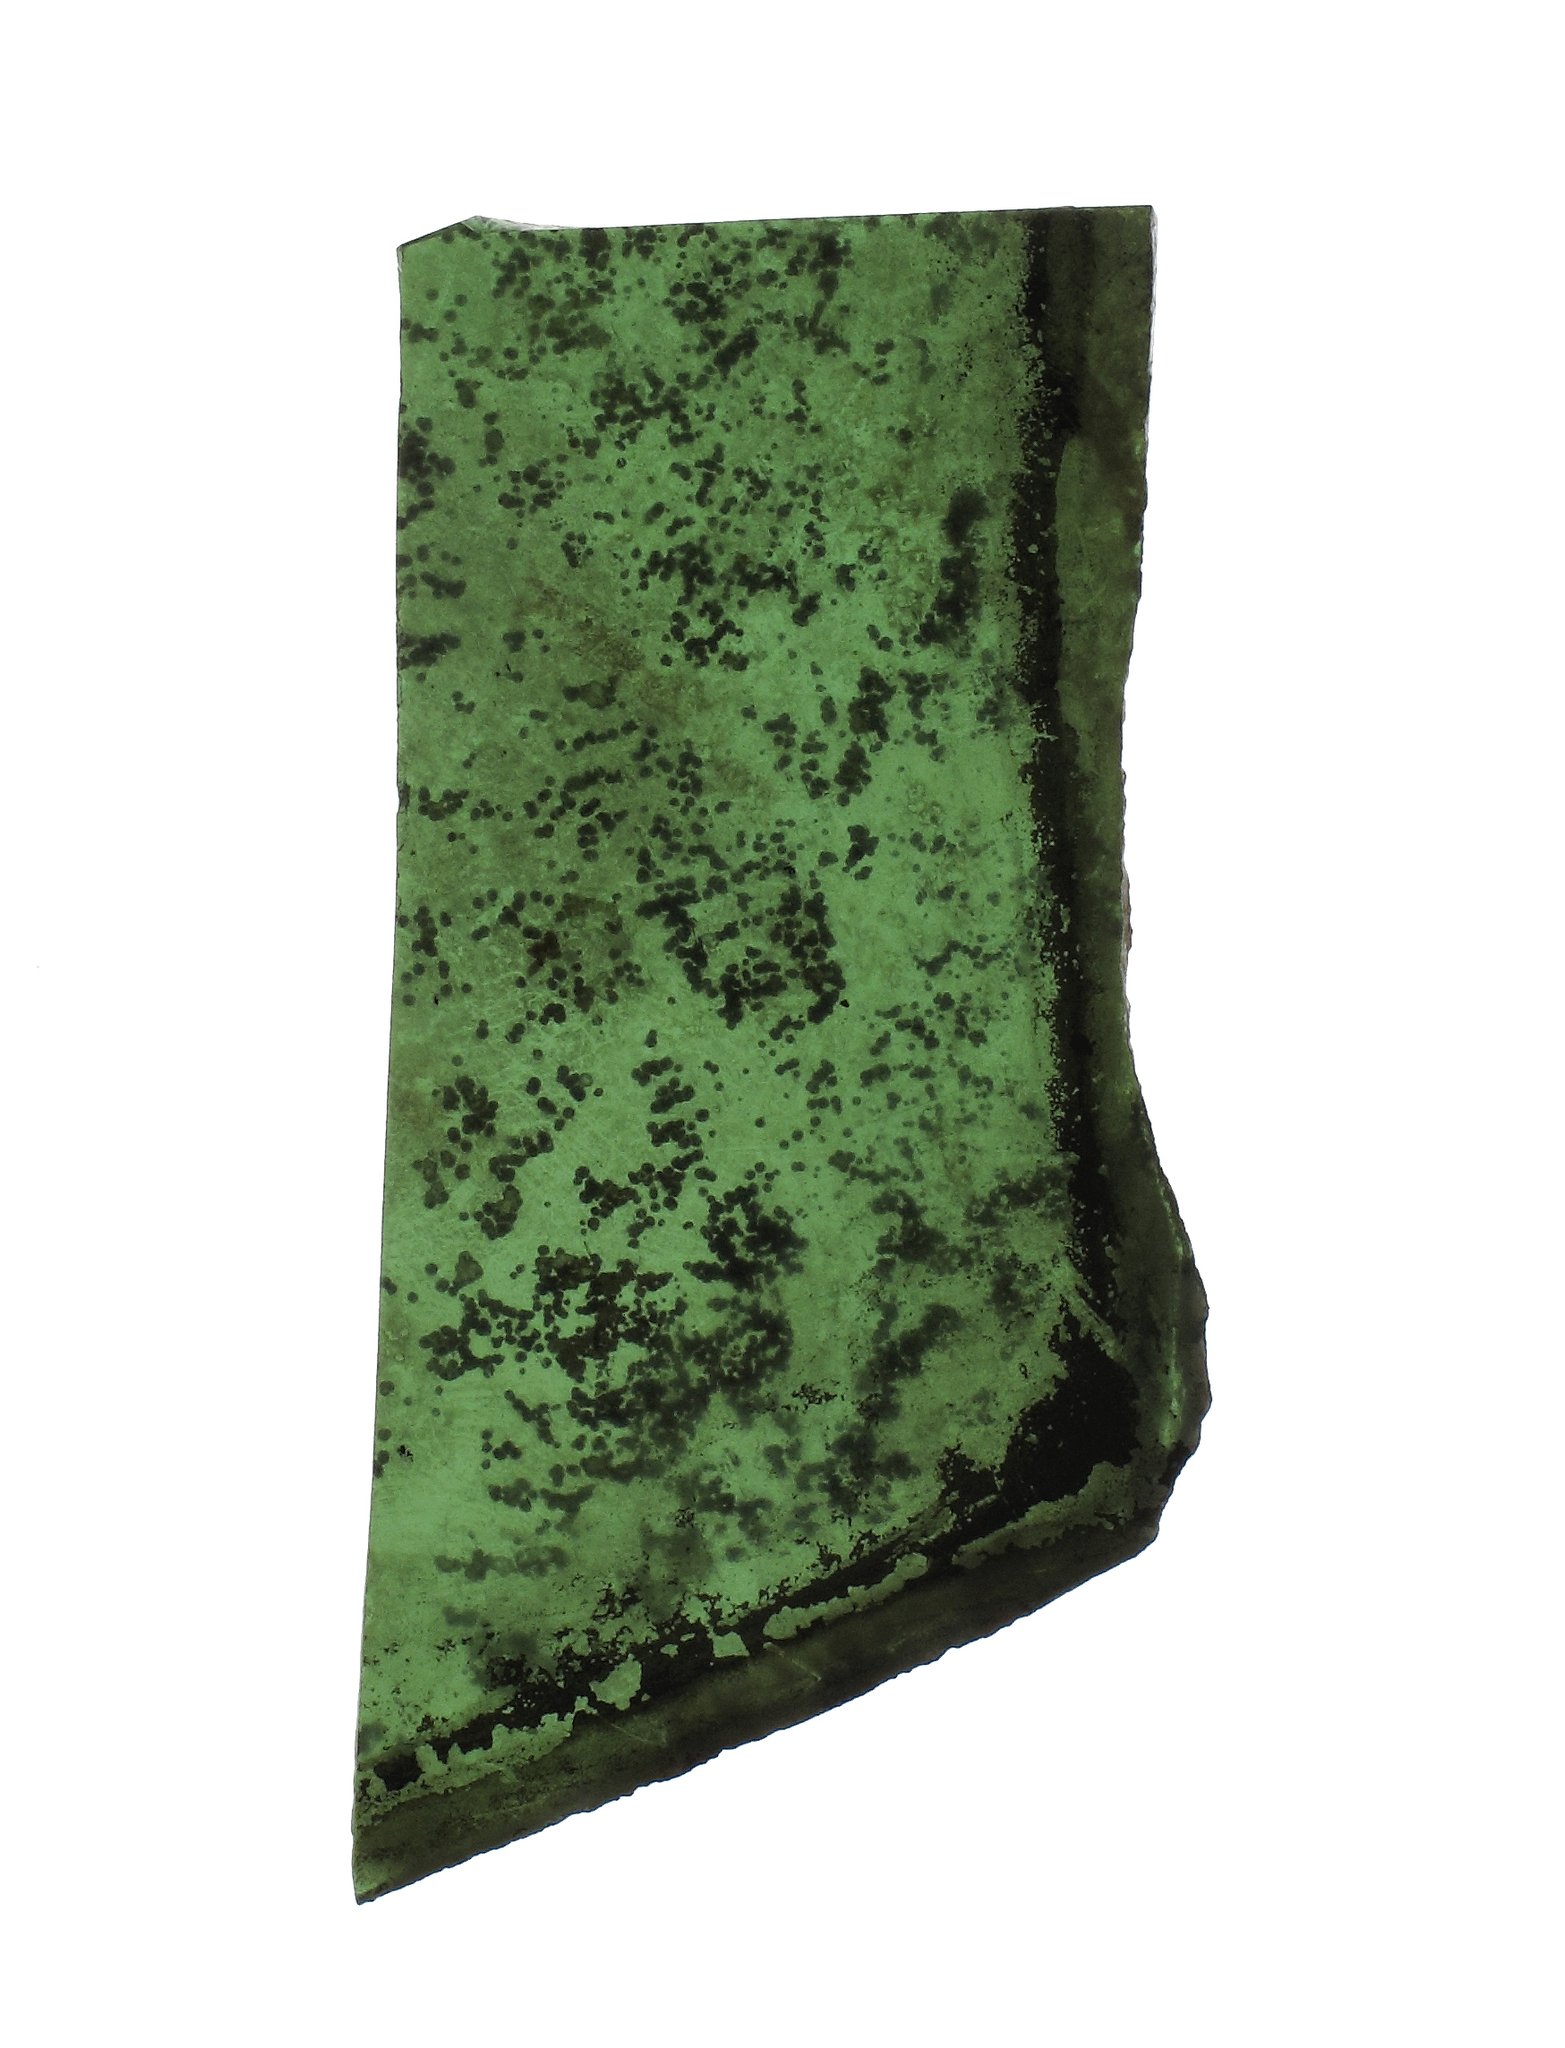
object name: fragment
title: Glass Fragment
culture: french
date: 1401-1500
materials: glass, metal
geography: france